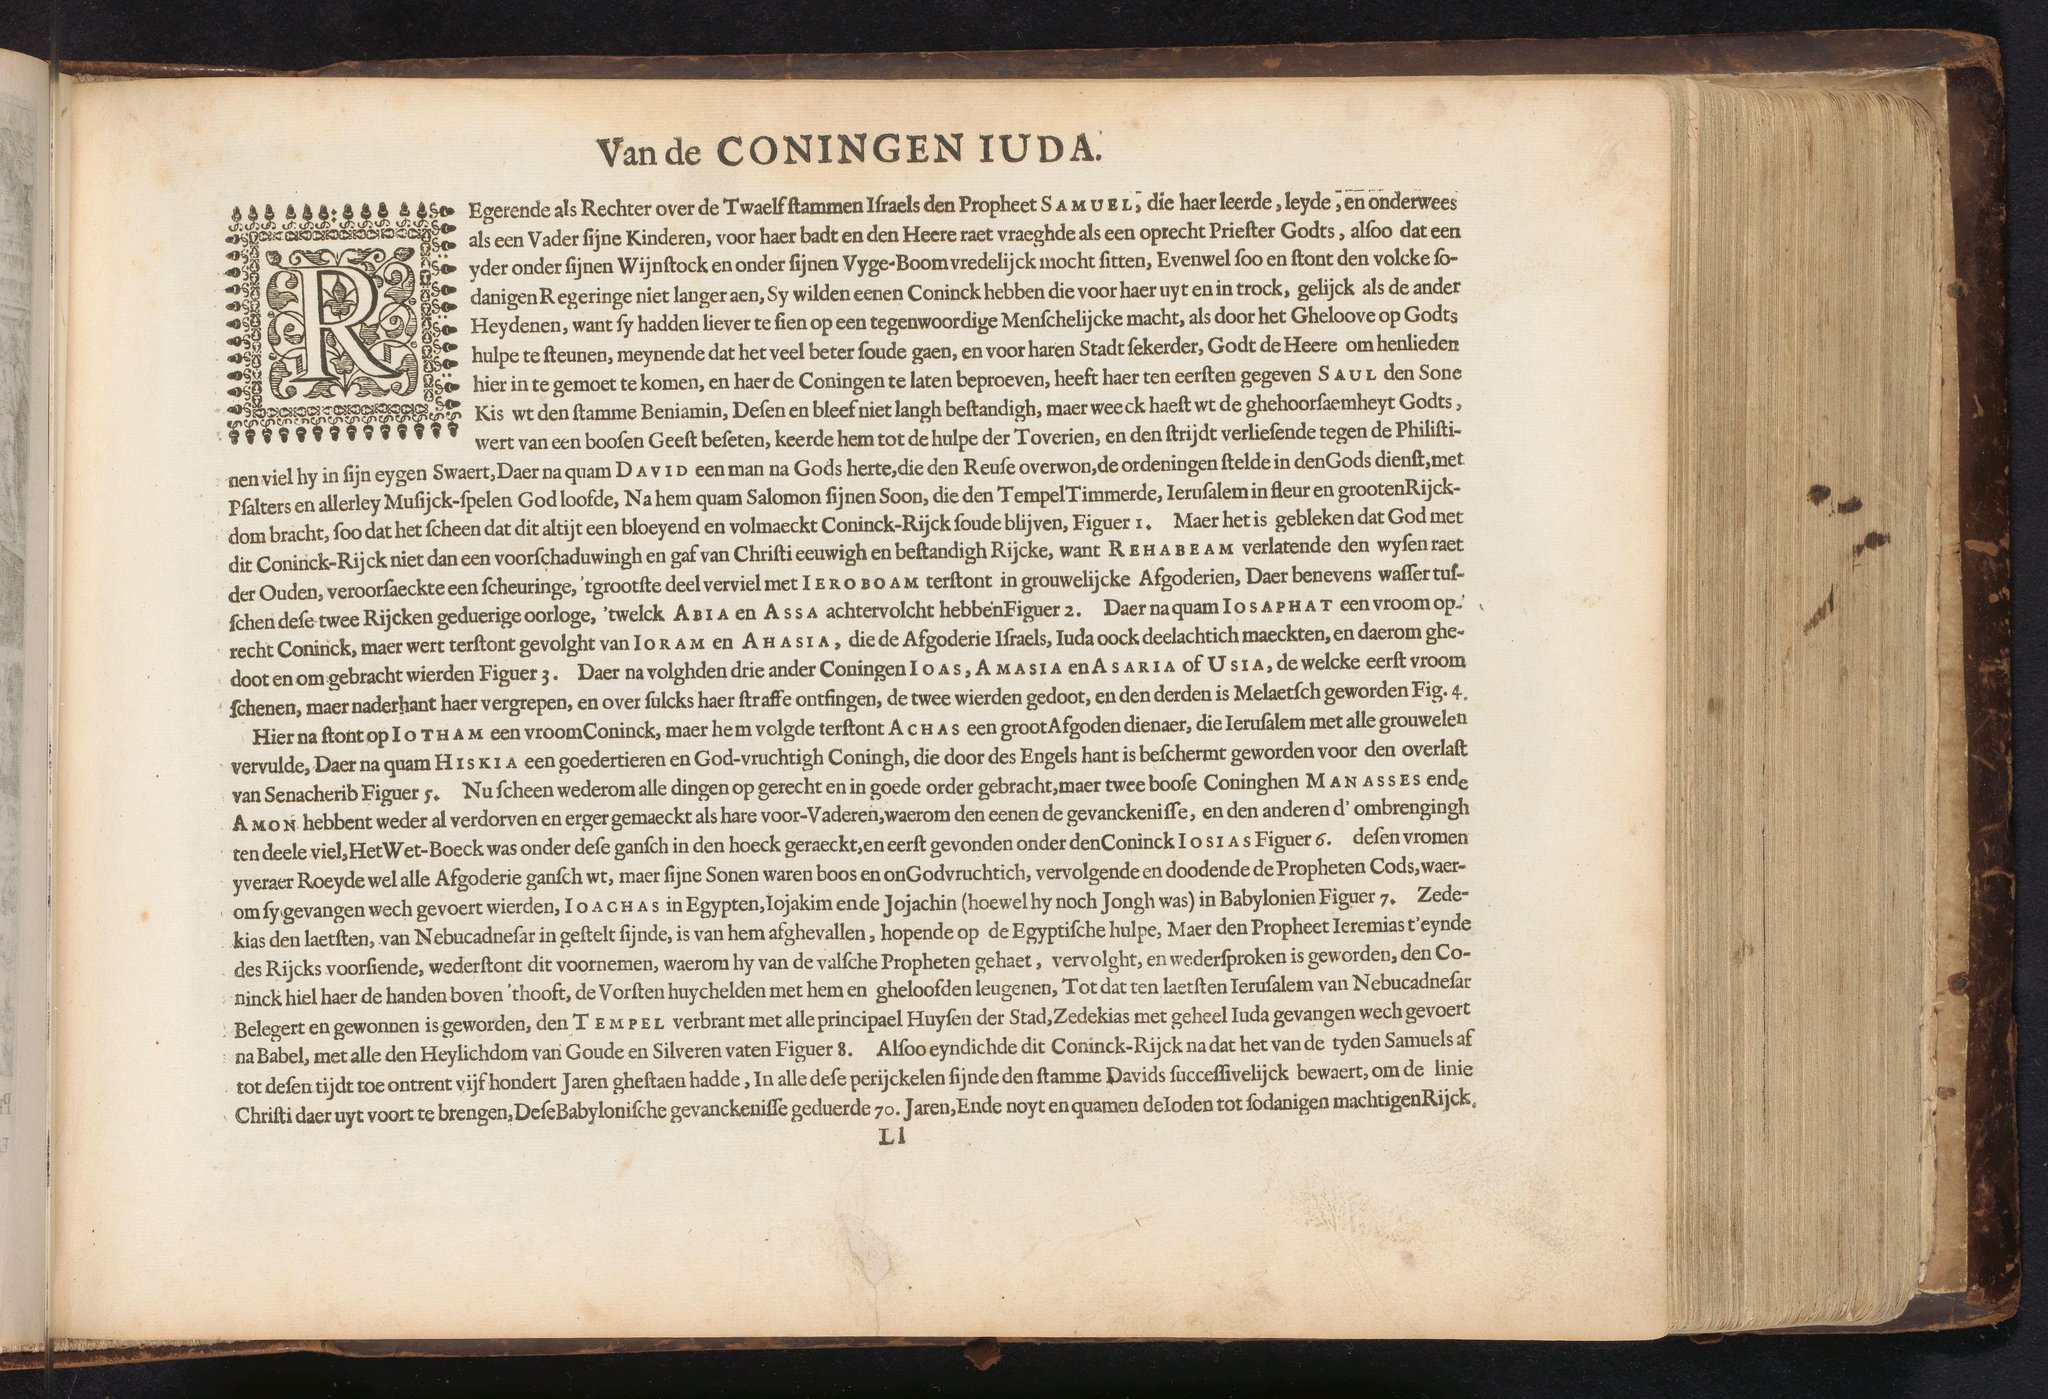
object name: album leaf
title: Den Grooten Figuer-Bibel (...)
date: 1646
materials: paper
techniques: letterpress printing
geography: alkmaar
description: Tekstblad bij een serie prenten over de koningen van Juda. Linksboven initiaal R. Dit blad maakt deel uit van een album.